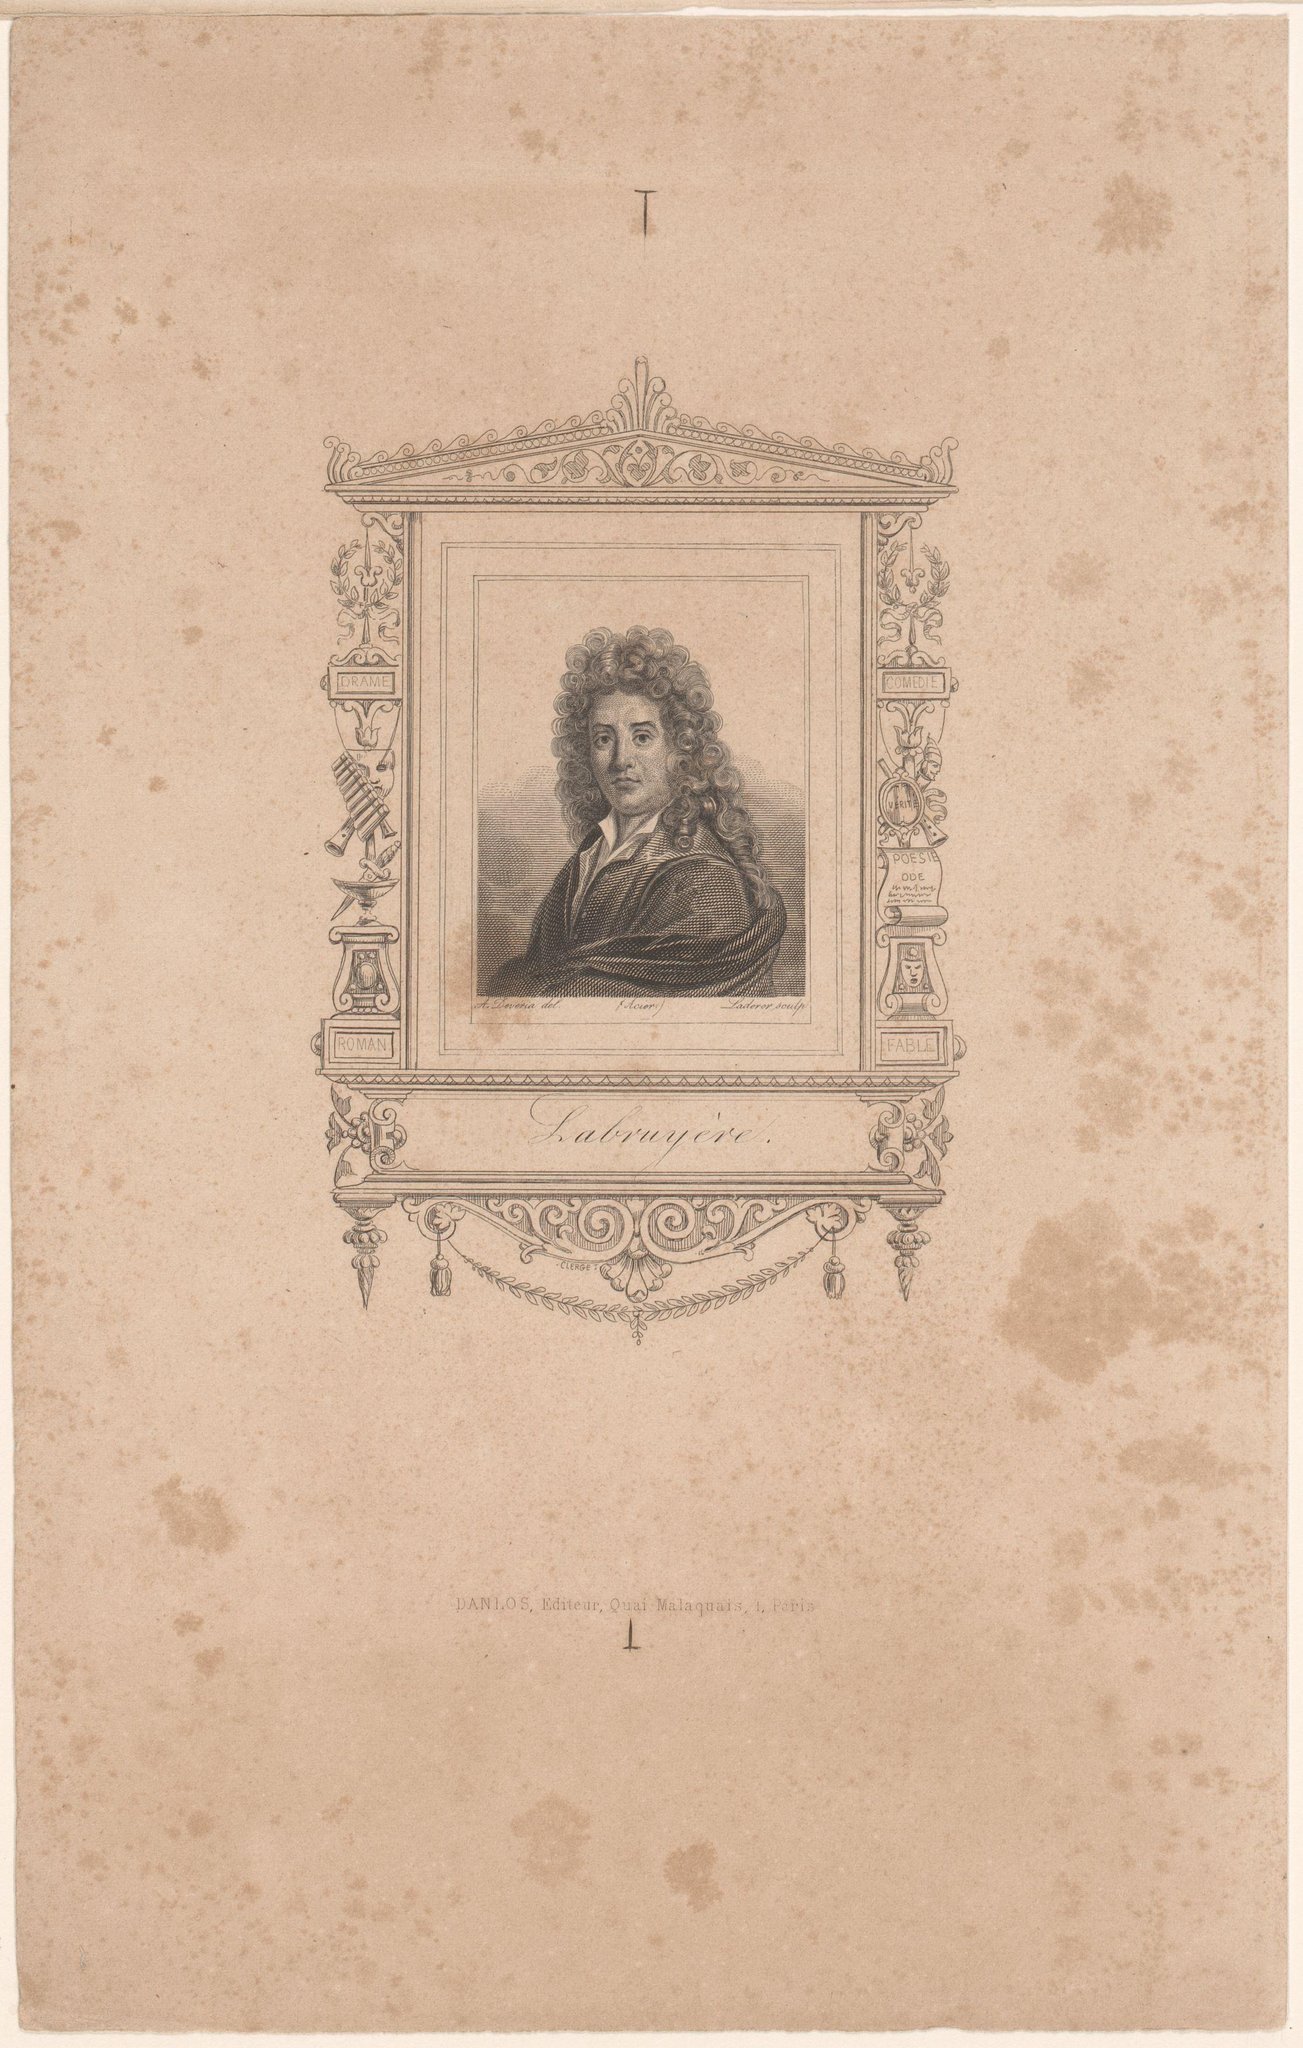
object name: print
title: Portret van Jean de La Bruyère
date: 1828-1899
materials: paper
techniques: engraving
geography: france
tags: historical persons, portrait of a writer, ornament ~ cartouche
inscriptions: collector's mark: Lugt 2228